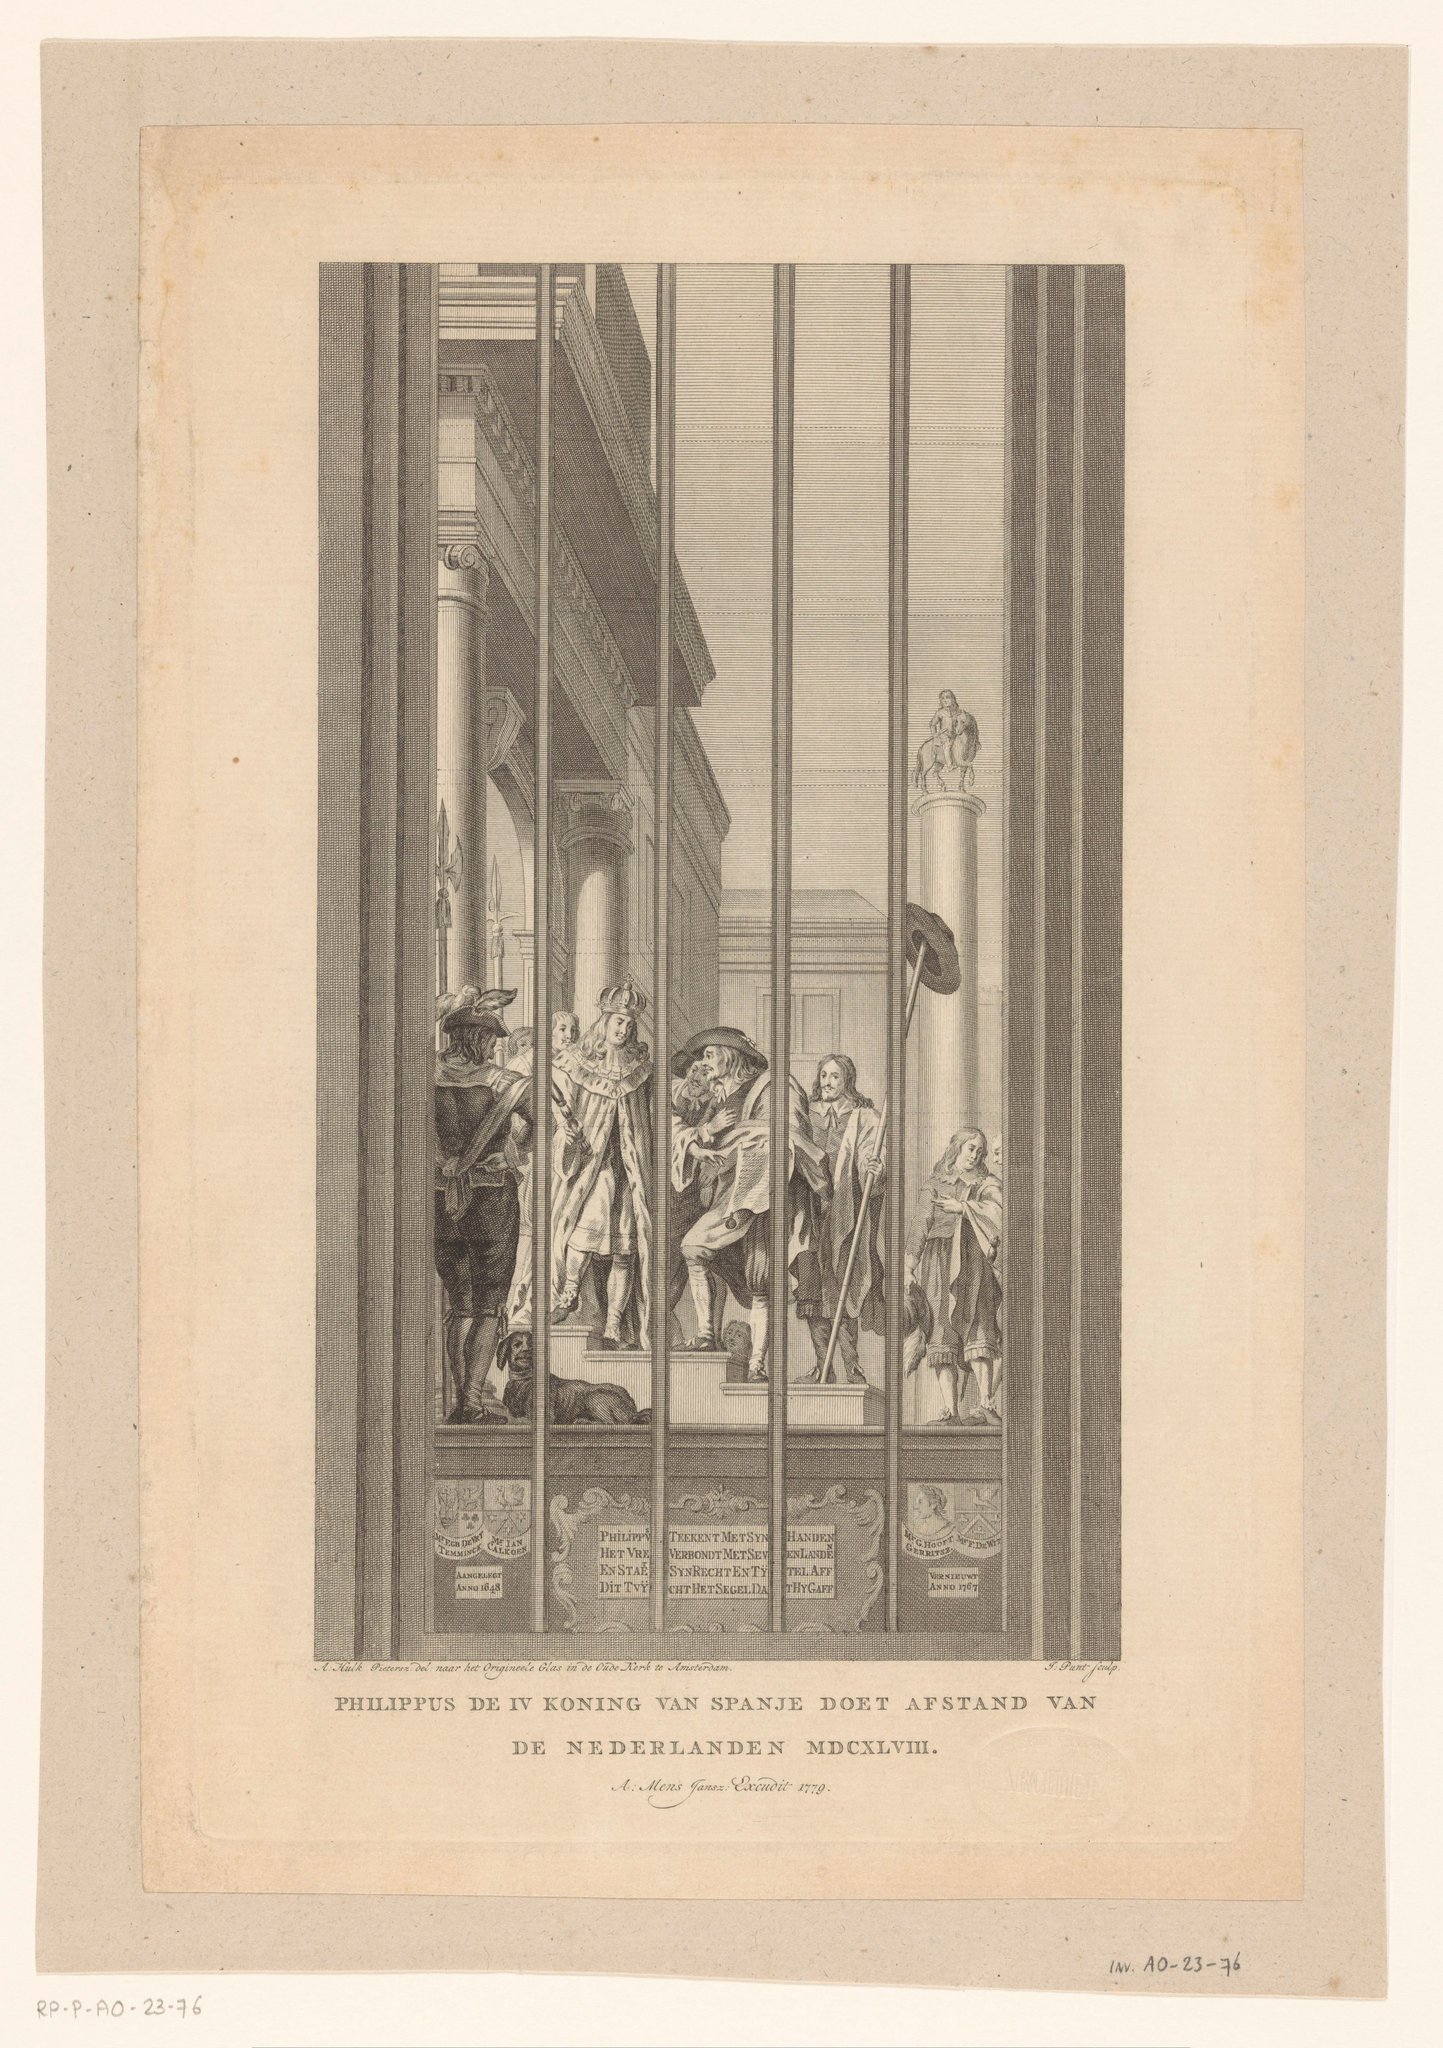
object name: historical object representation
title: Philippus de IV koning van Spanje doet afstand van de Nederlanden MDCXLVIII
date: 1779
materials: paper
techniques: engraving, etching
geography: amsterdam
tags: filips iv (koning van spanje), church-window, e.g. rose-window, signing of peace treaty, concluding the peace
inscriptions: check stamp: ‘Archief Ministerie van Oorlog Afdeeling Genie’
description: Glas-in-loodraam met een voorstelling van de Spaanse koning Filips IV die een document voorgehouden krijgt waarin hij afstand doet van de Nederlanden, na het sluiten van de Vrede van Munster, 1648. In een cartouche een vers van vier regels. Glas-in-loodraam in de Oude Kerk te Amsterdam geplaatst in 1656 en vernieuwd in 1767.